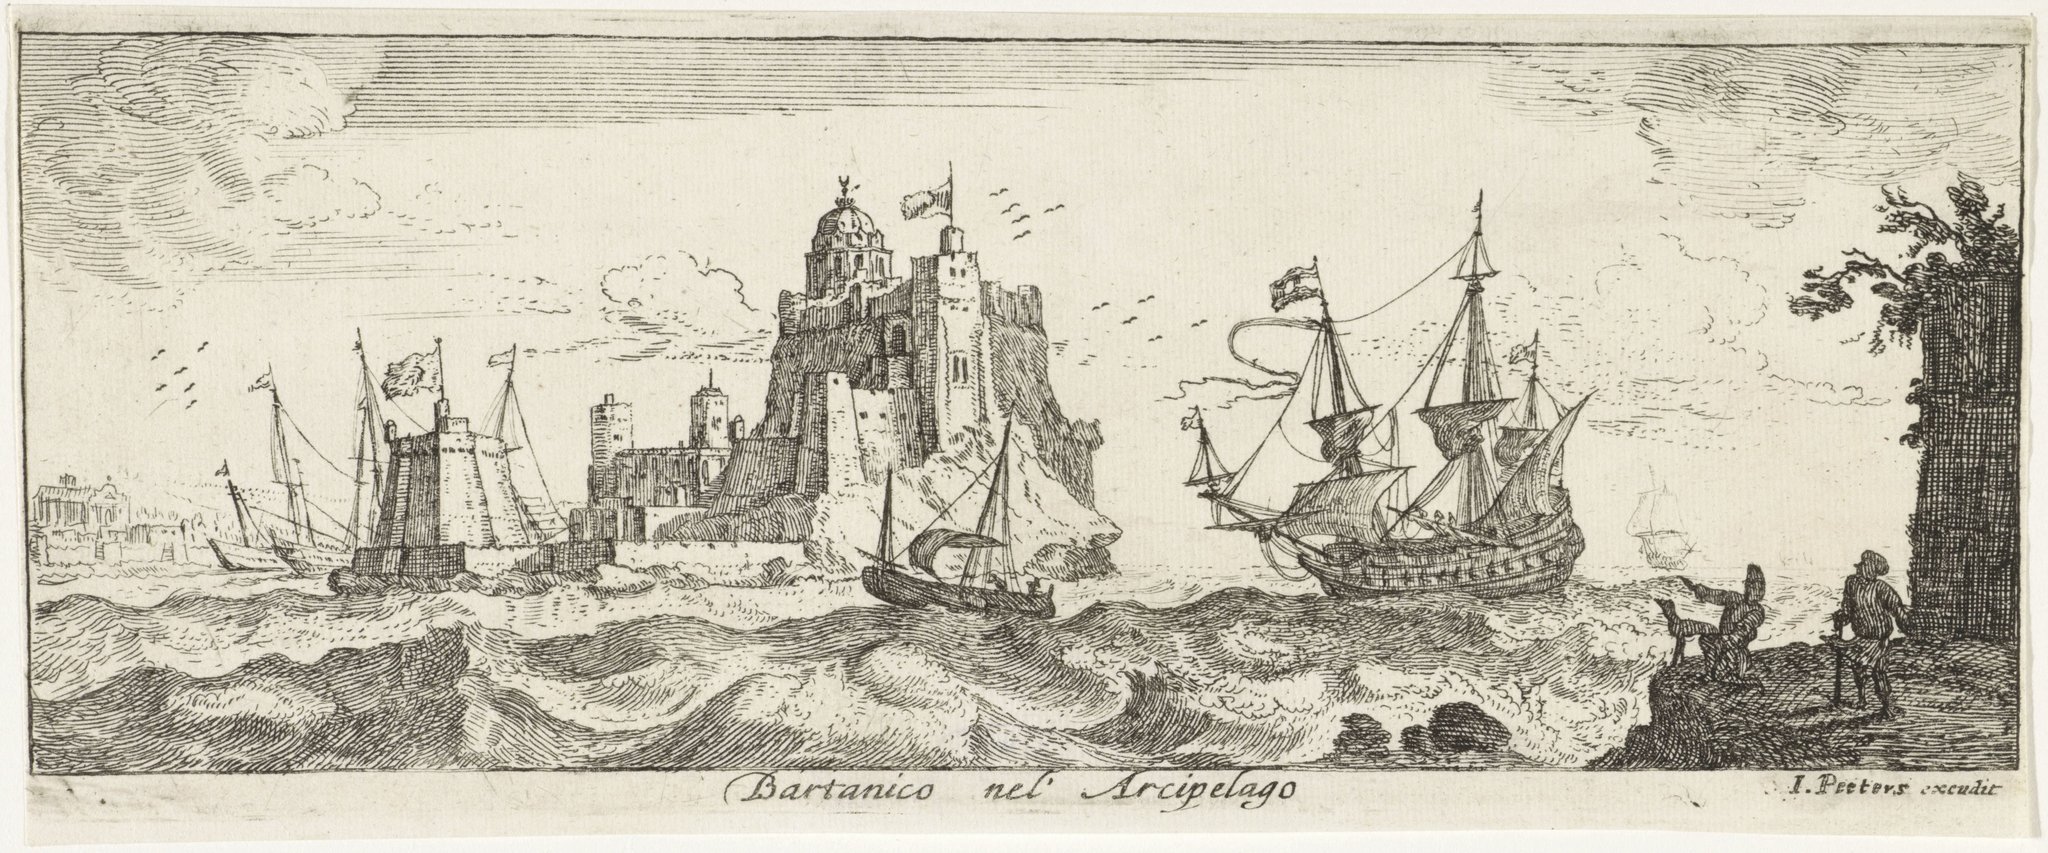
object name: print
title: Gezicht op een havenstad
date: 1683-1685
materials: paper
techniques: etching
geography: antwerp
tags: harbour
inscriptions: collector's mark: Lugt 2228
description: Prent gebruikt in: Description des principales villes, havres et isles du golfe de Venise du cote oriental, comme aussi des villes et fortresses de la Moree et quelques places de la Grece et es isles principales de l'Archipel et fortresses dícelles et en suittes quelques places renommées de la Terre Saincte, et autres dessous la domination Ottomane vers le Midij et l'Orient, et quelques principales villes en Perse et le regne du Grand Mogol le tout en Abrege. Antwerpen: Jacob Peeters, s.a.